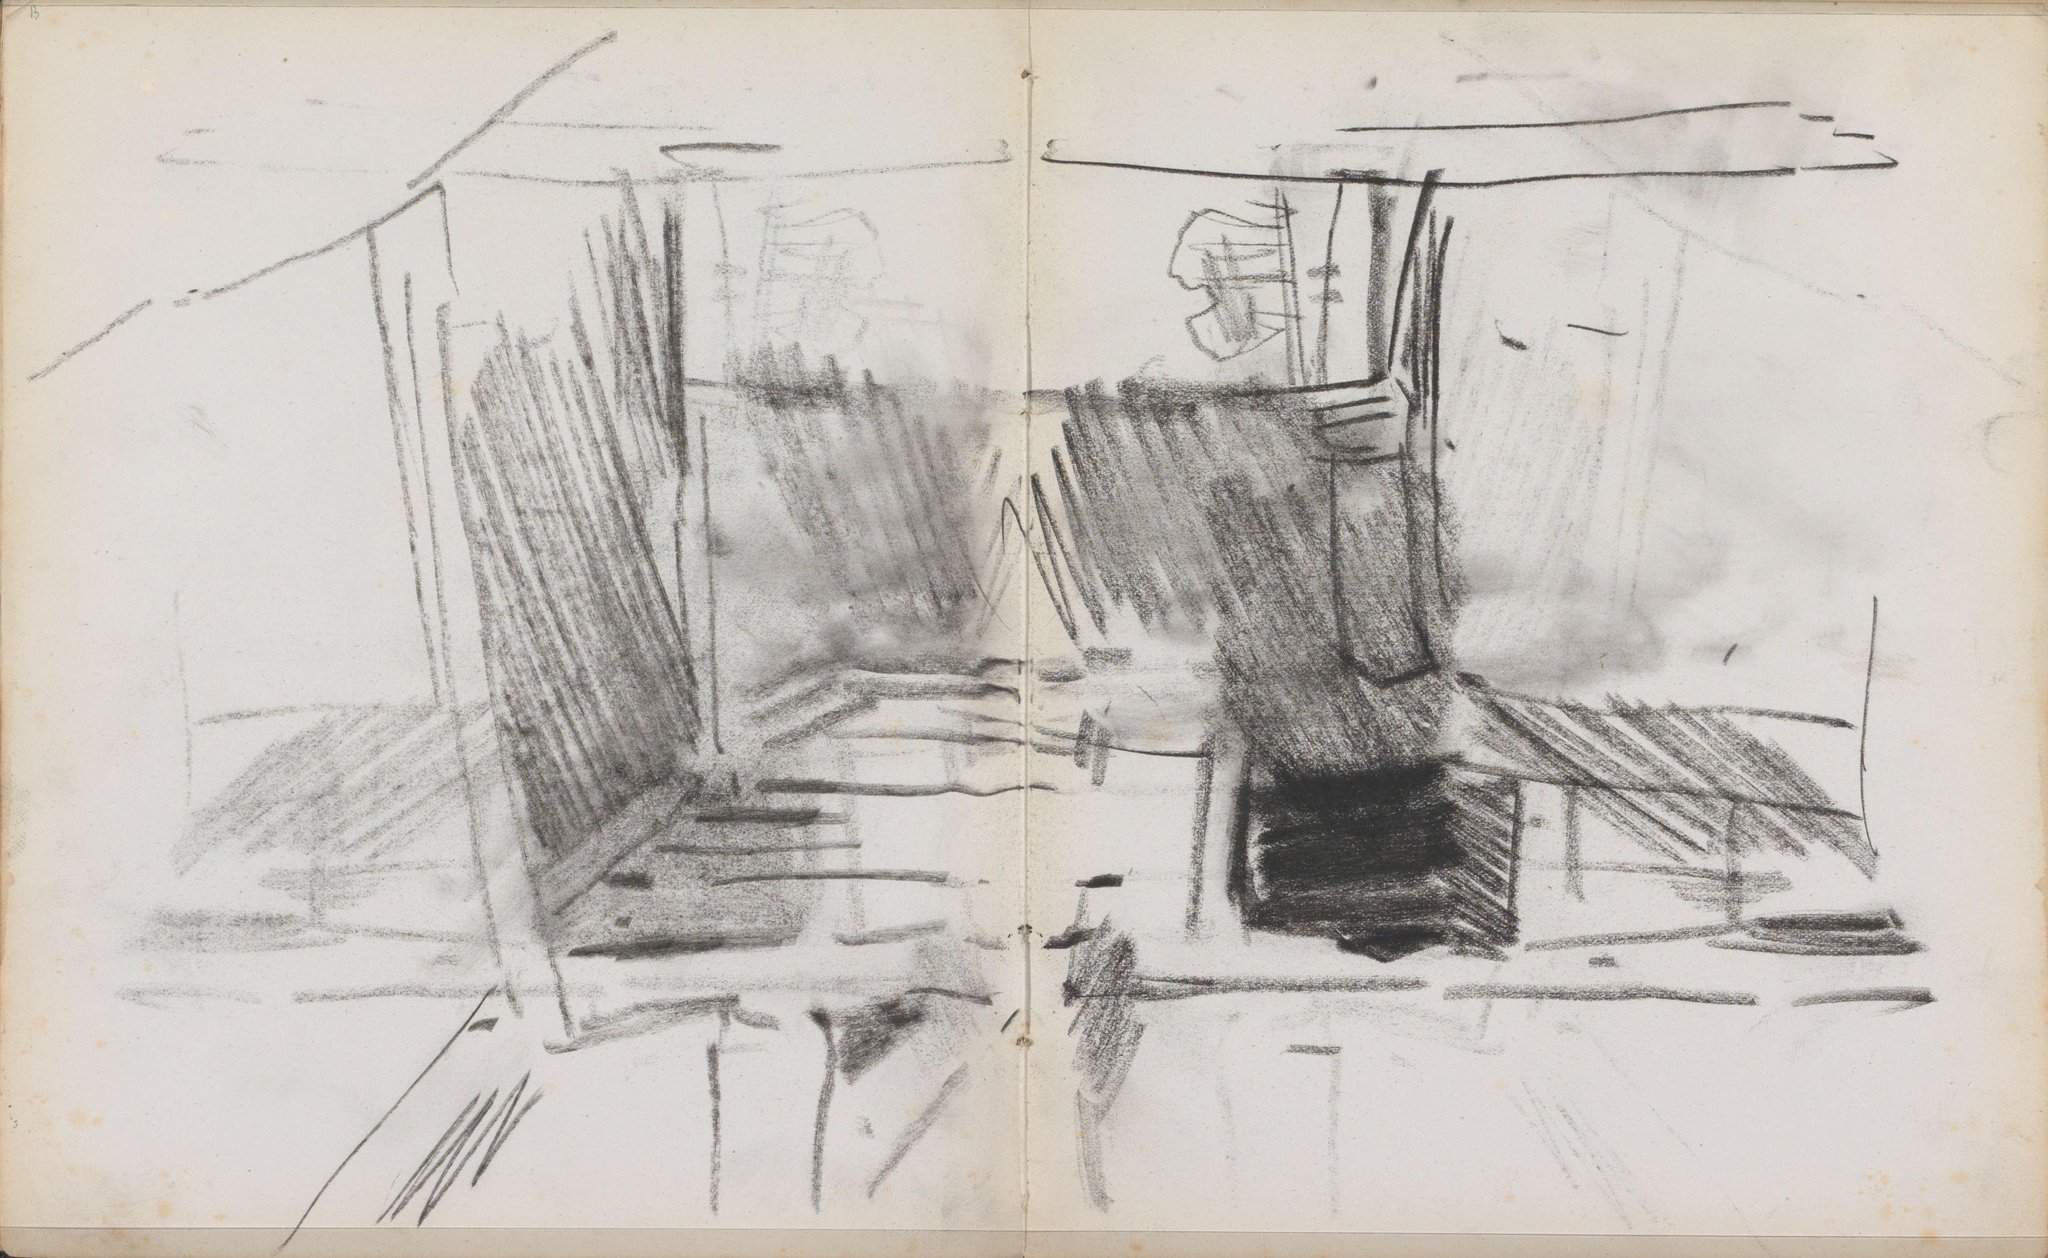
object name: sketchbook leaf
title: Doorgang of poort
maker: george hendrik breitner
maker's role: draughtsman, painter, print maker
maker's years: 1857-1923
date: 1880-1906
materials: chalk, paper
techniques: stumping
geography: netherlands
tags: gate, entrance, passage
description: Pagina 13 en pagina 14 uit een schetsboek met 81 bladen.